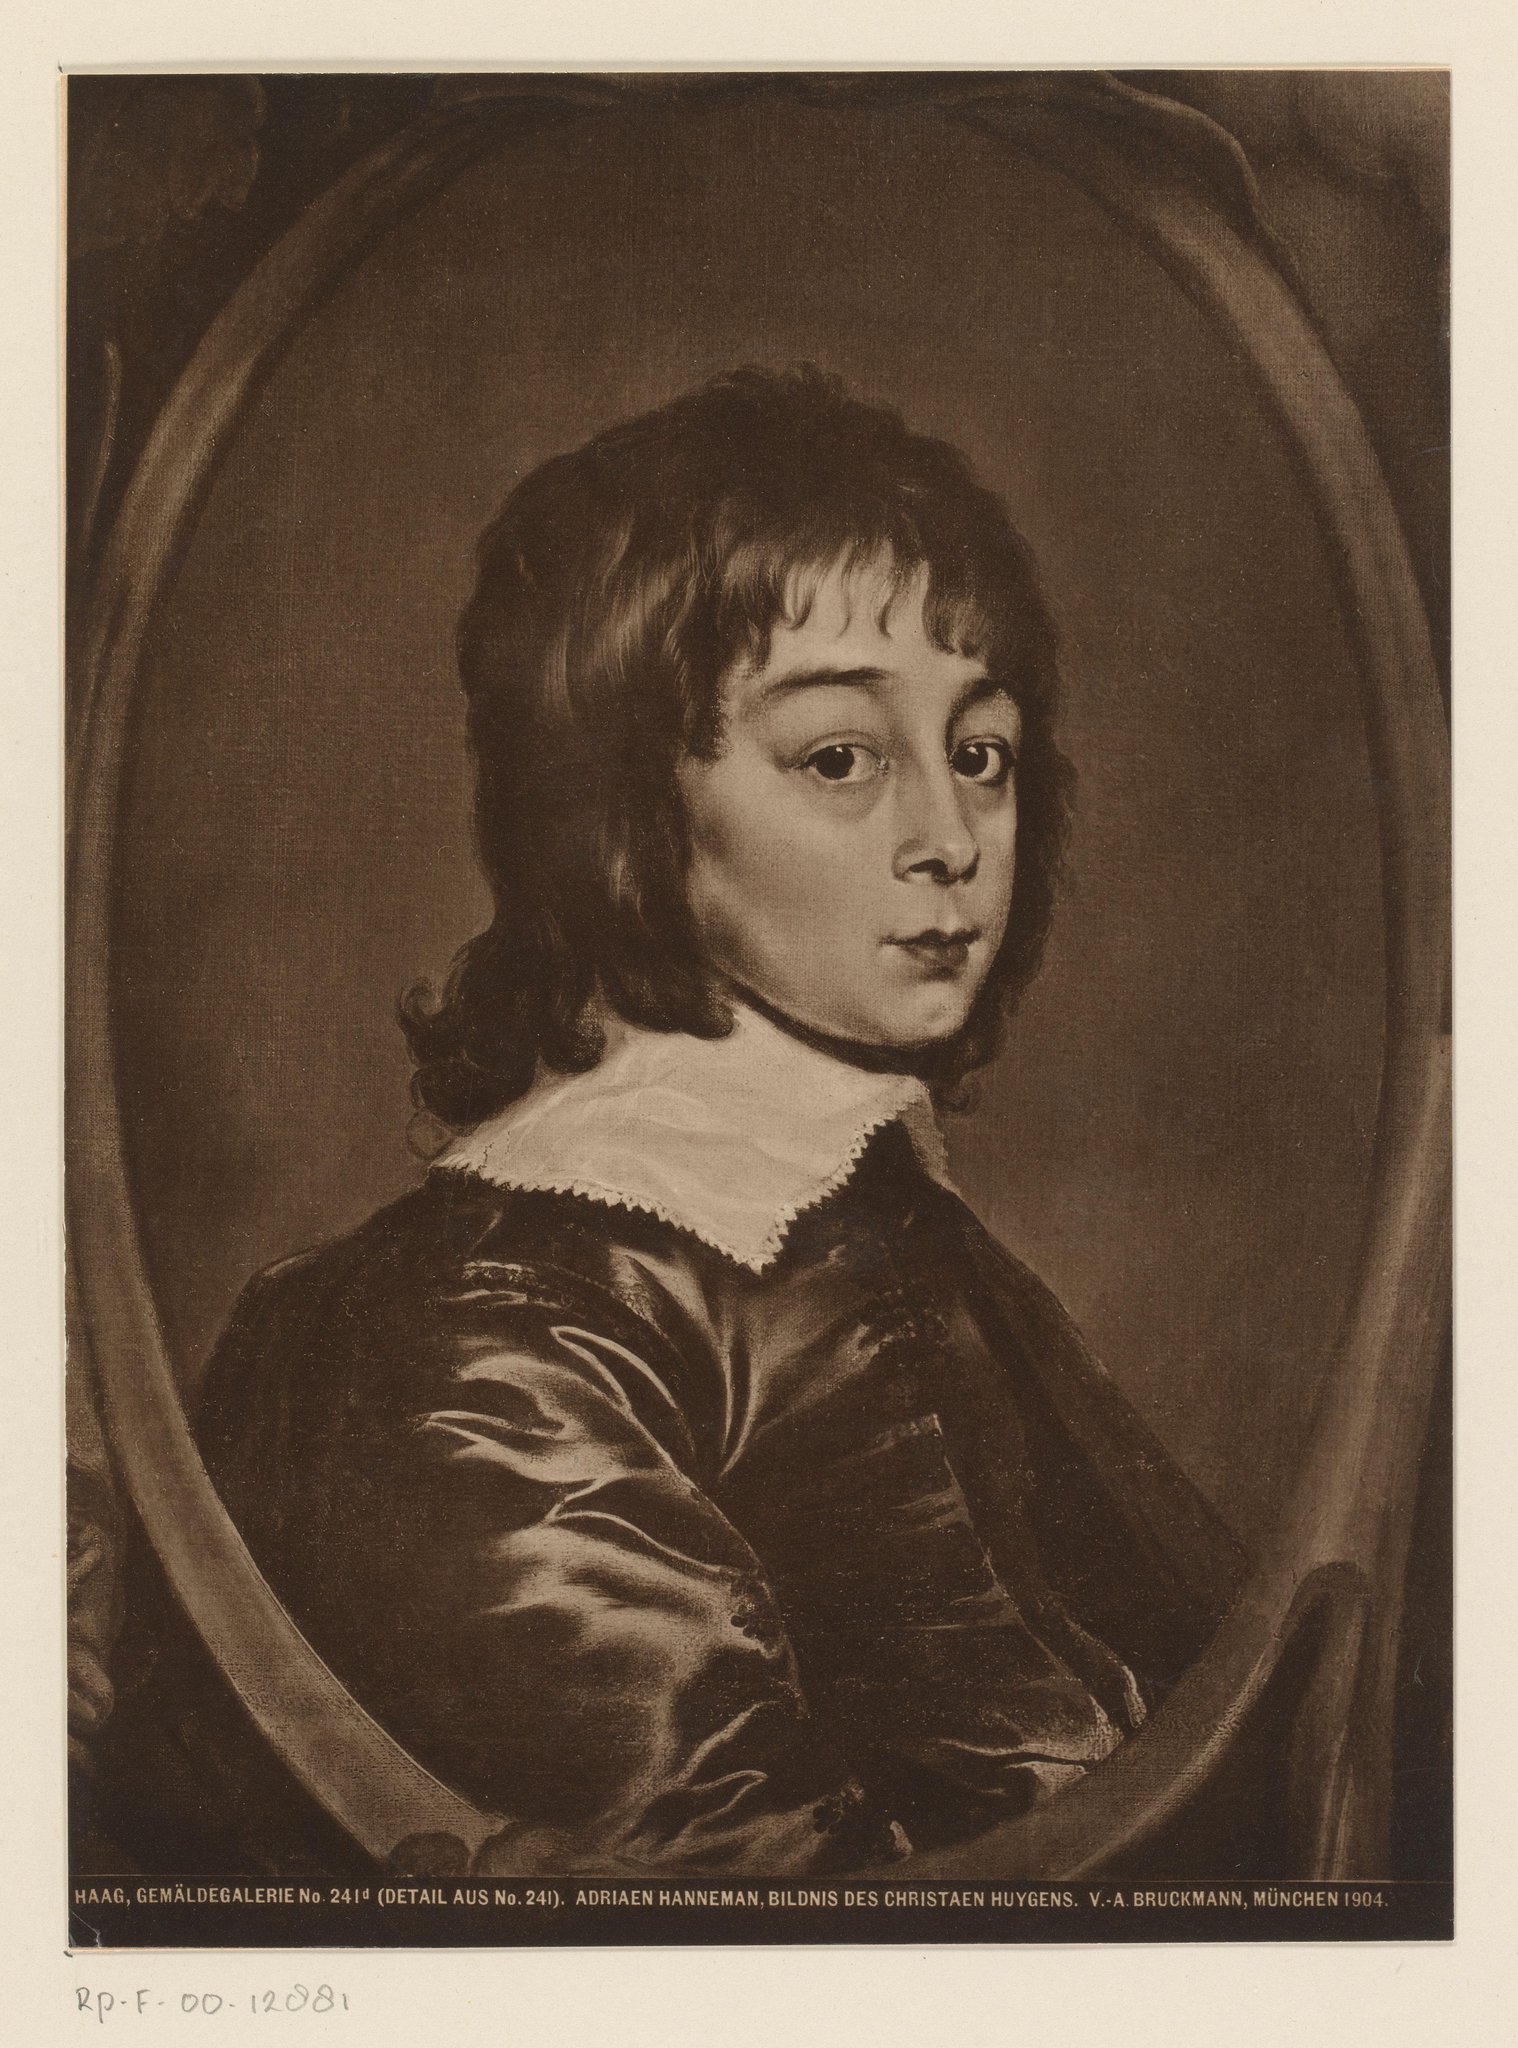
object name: reproduction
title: Reproductie van een detail van een geschilderd portret van Christiaan Huygens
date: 1904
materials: paper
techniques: photograph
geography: munich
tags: the hague, christiaan huygens (ii), historical persons, picture, painting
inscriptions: inscription: ‘HAAG, GEMÄLDEGALERIE No. 241d (DETAIL AUS No. 241).’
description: Reproductie van een detail van het schilderij Portret van Constantijn Huygens (1596-1687) en zijn vijf kinderen door Adriaen Hanneman in de collectie van het Mauritshuis, Den Haag.